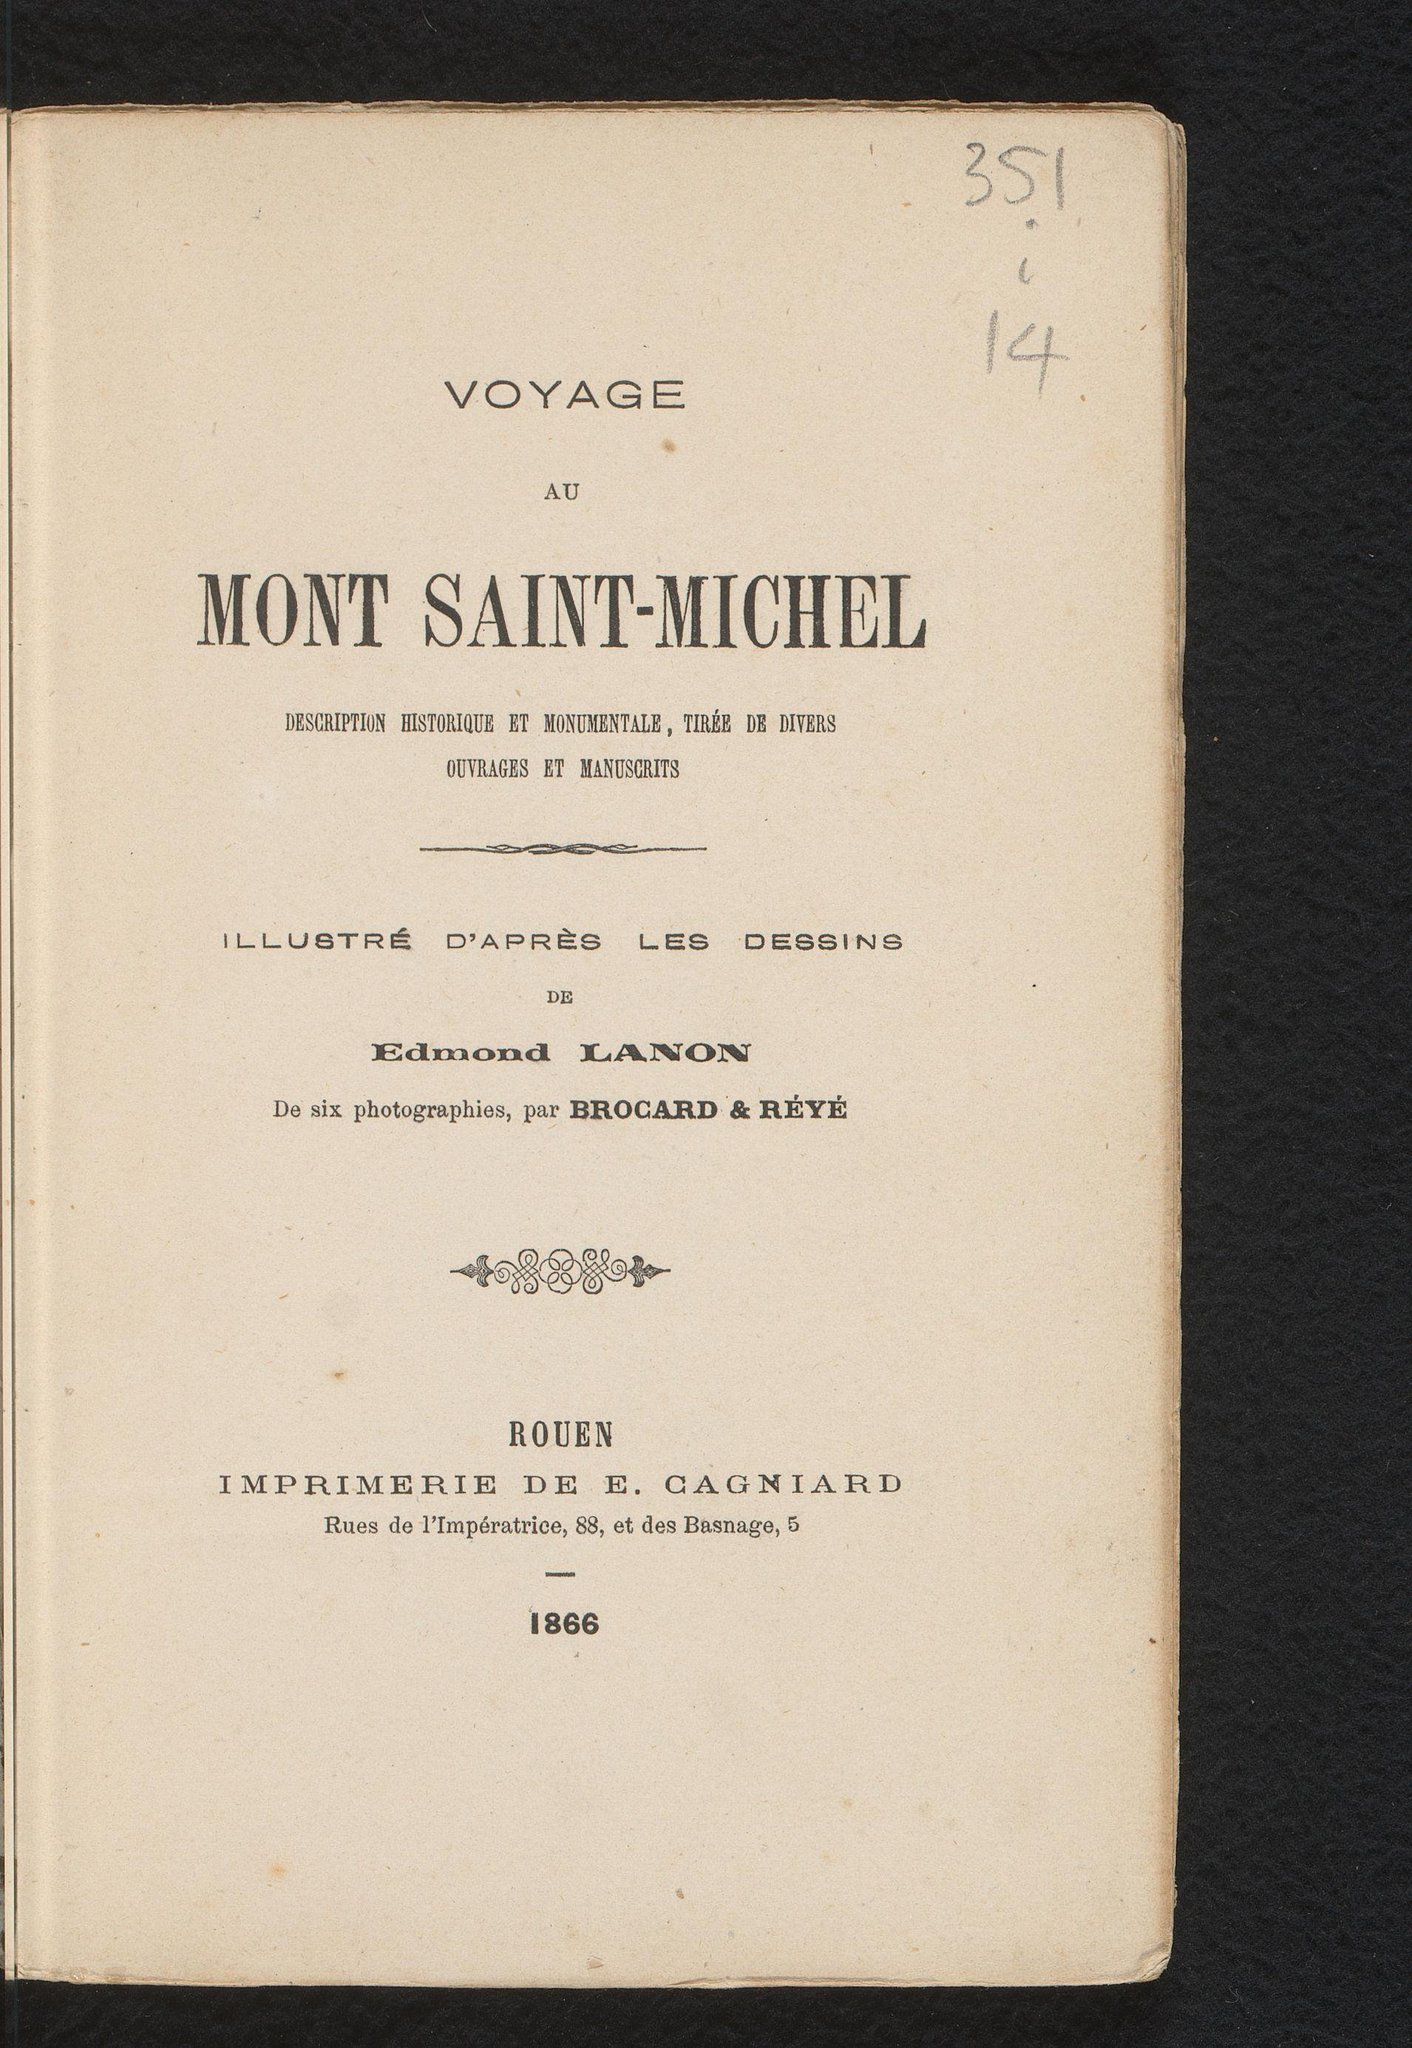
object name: book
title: Voyage au Mont Saint-Michel : description historique et monumentale, tirée de divers ouvrages et manuscrits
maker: espérance cagniard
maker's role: printer, publisher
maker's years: 1825-1891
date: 1866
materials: cardboard, paper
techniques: albumen print, etching, letterpress printing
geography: rouen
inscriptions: inscription: ‘Complet/ f20,-’